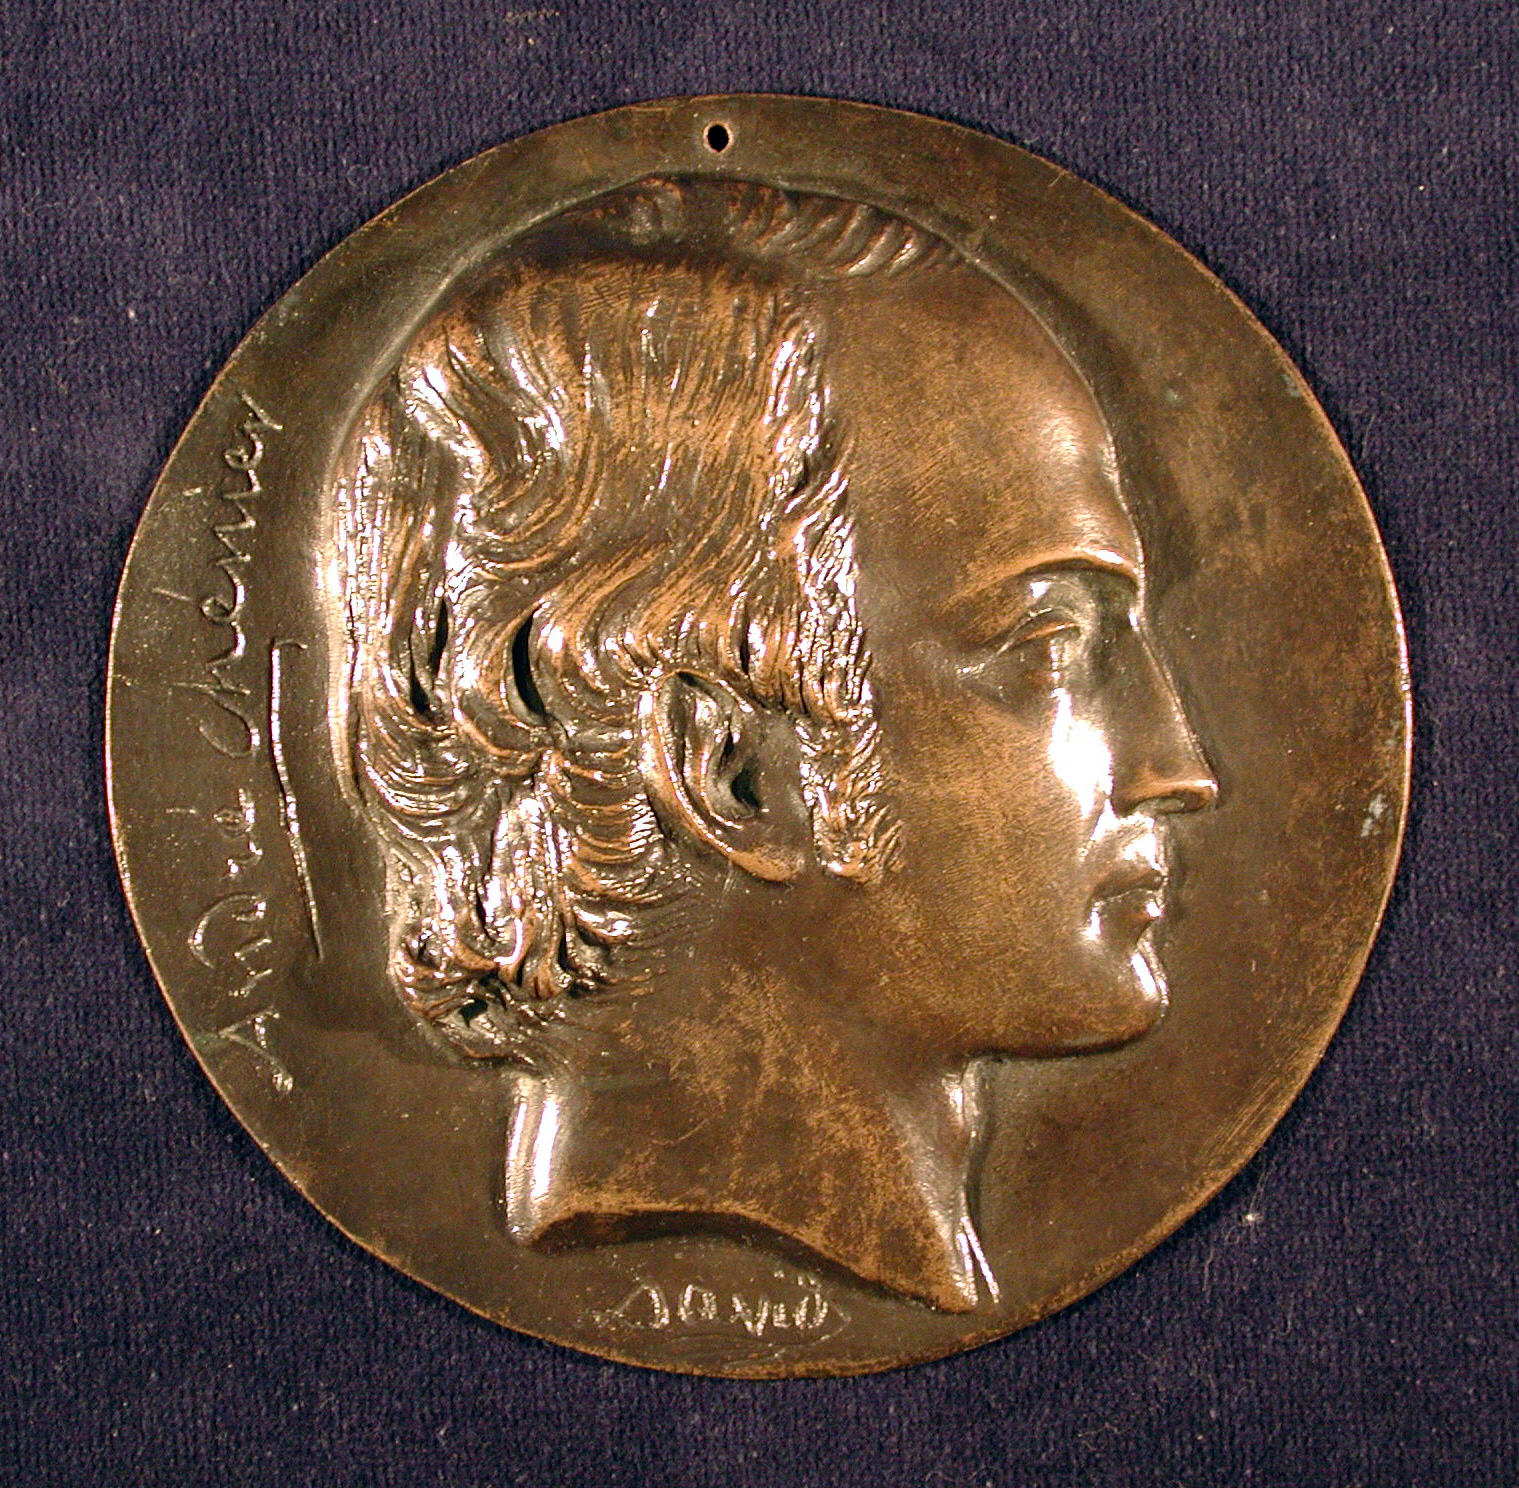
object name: medallion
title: André Chénier, Poet (1762–1794)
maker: pierre jean david d'angers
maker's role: artist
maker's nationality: french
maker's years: 1788-1856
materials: bronze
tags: men,profiles